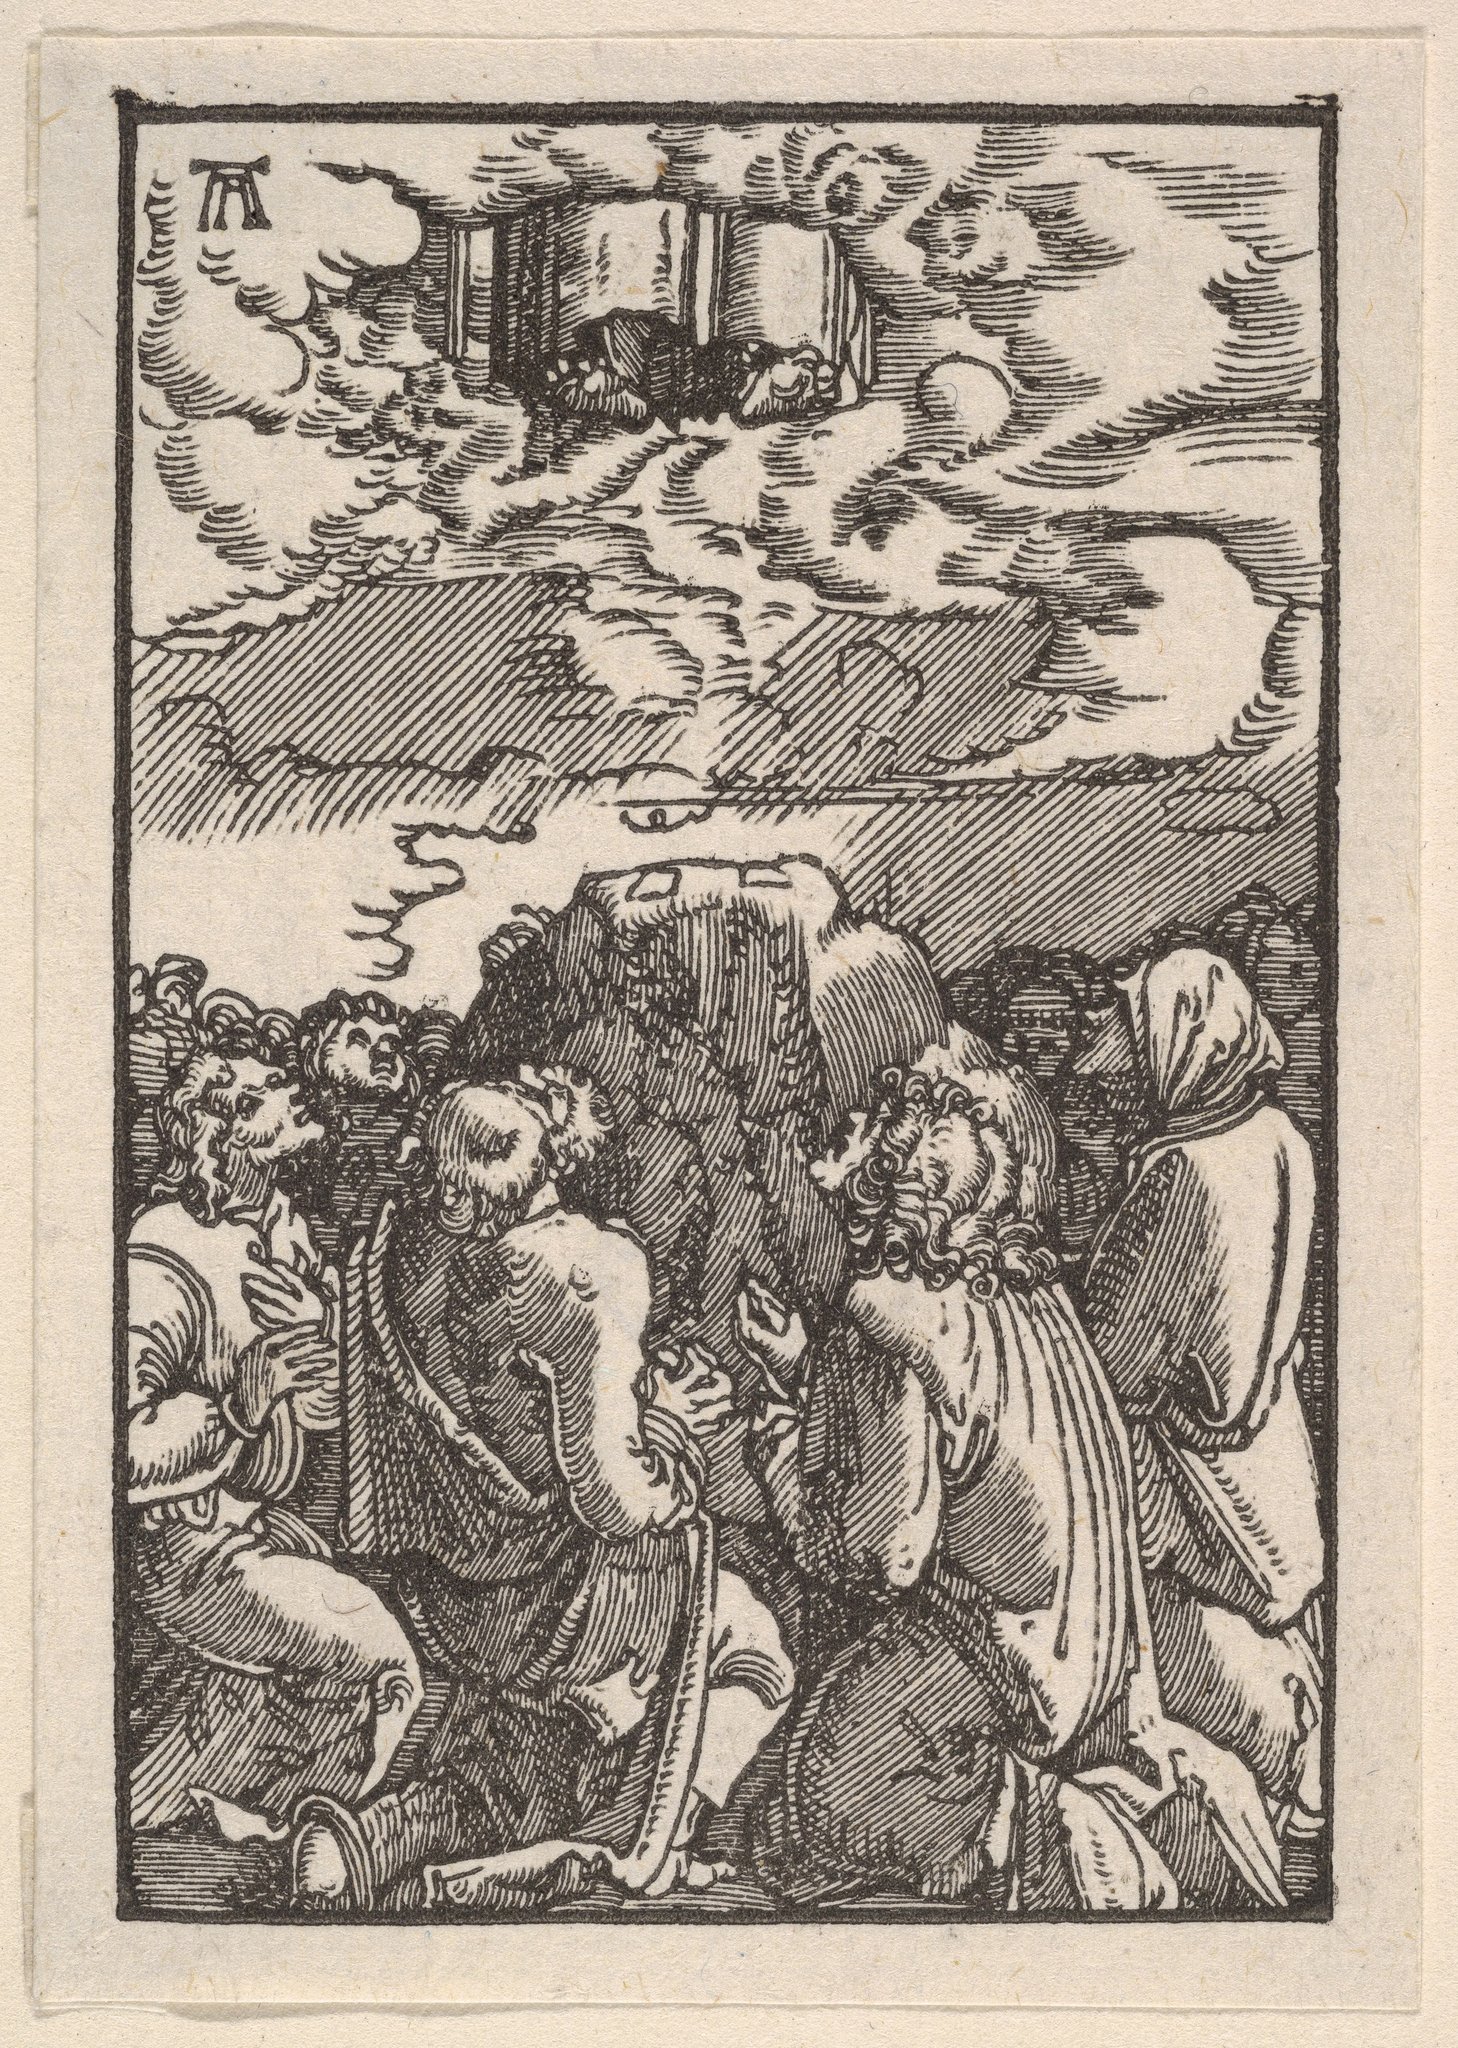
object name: print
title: The Ascension of Christ, from "The Fall and Salvation of Mankind Through the Life and Passion of Christ"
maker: albrecht altdorfer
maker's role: artist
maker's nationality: german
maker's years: 1480-1538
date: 1513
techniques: woodcut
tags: men,christ